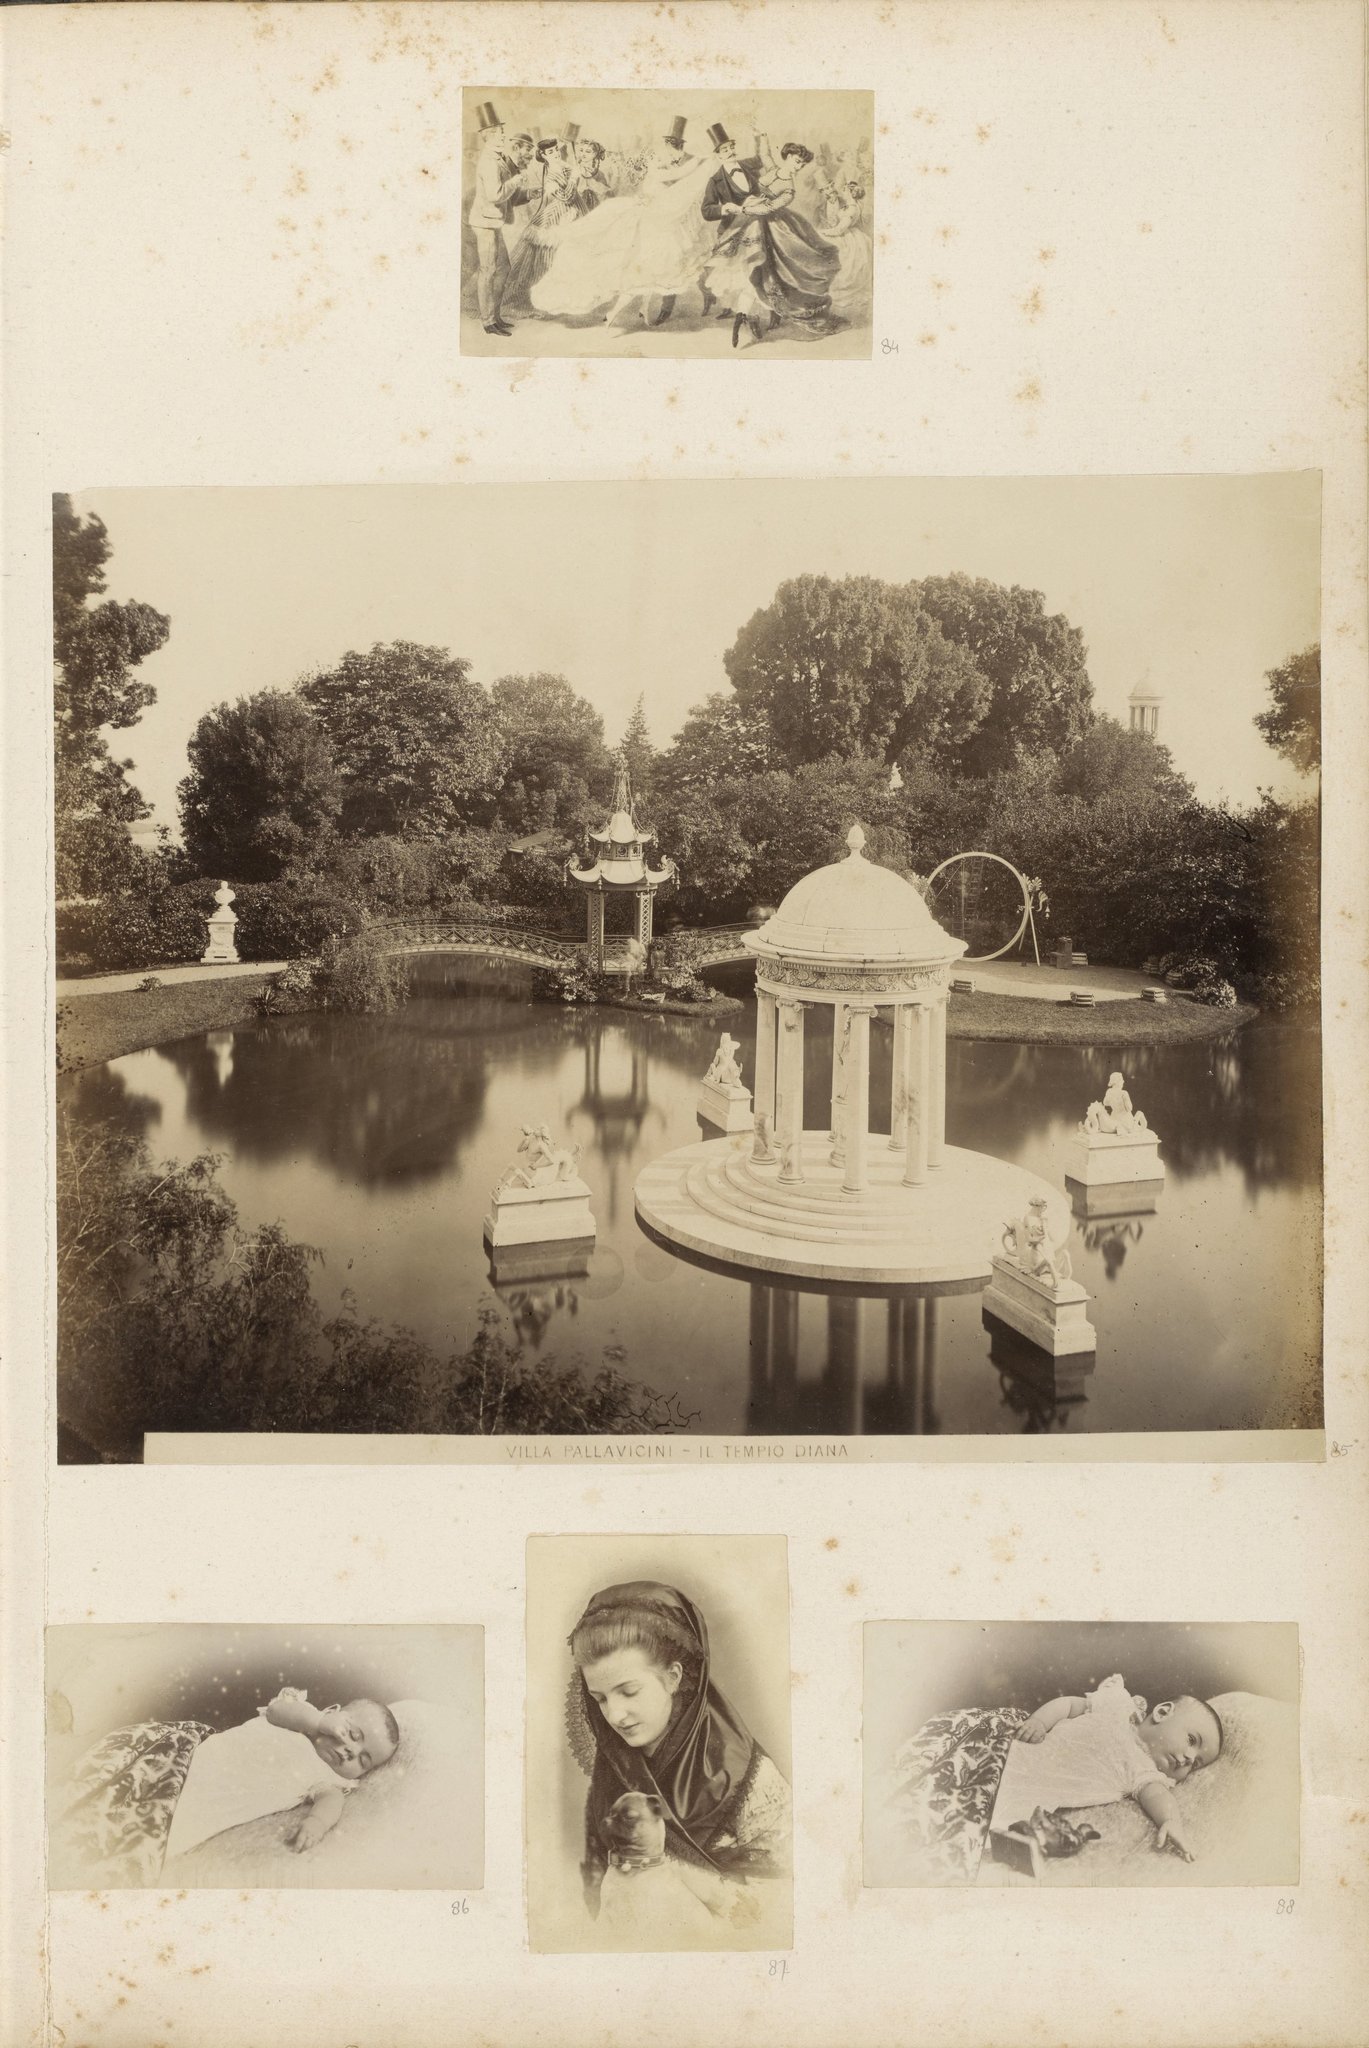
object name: album leaf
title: Fotoreproductie van (vermoedelijk) een prent van danskoppels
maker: Anonymous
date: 1870-1880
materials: paper, photographic support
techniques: albumen print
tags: dancing, night-club, dance-hall (+ variant)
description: Onderdeel van Fotoalbum van Robert Daniel Crommelin (1841-1907).